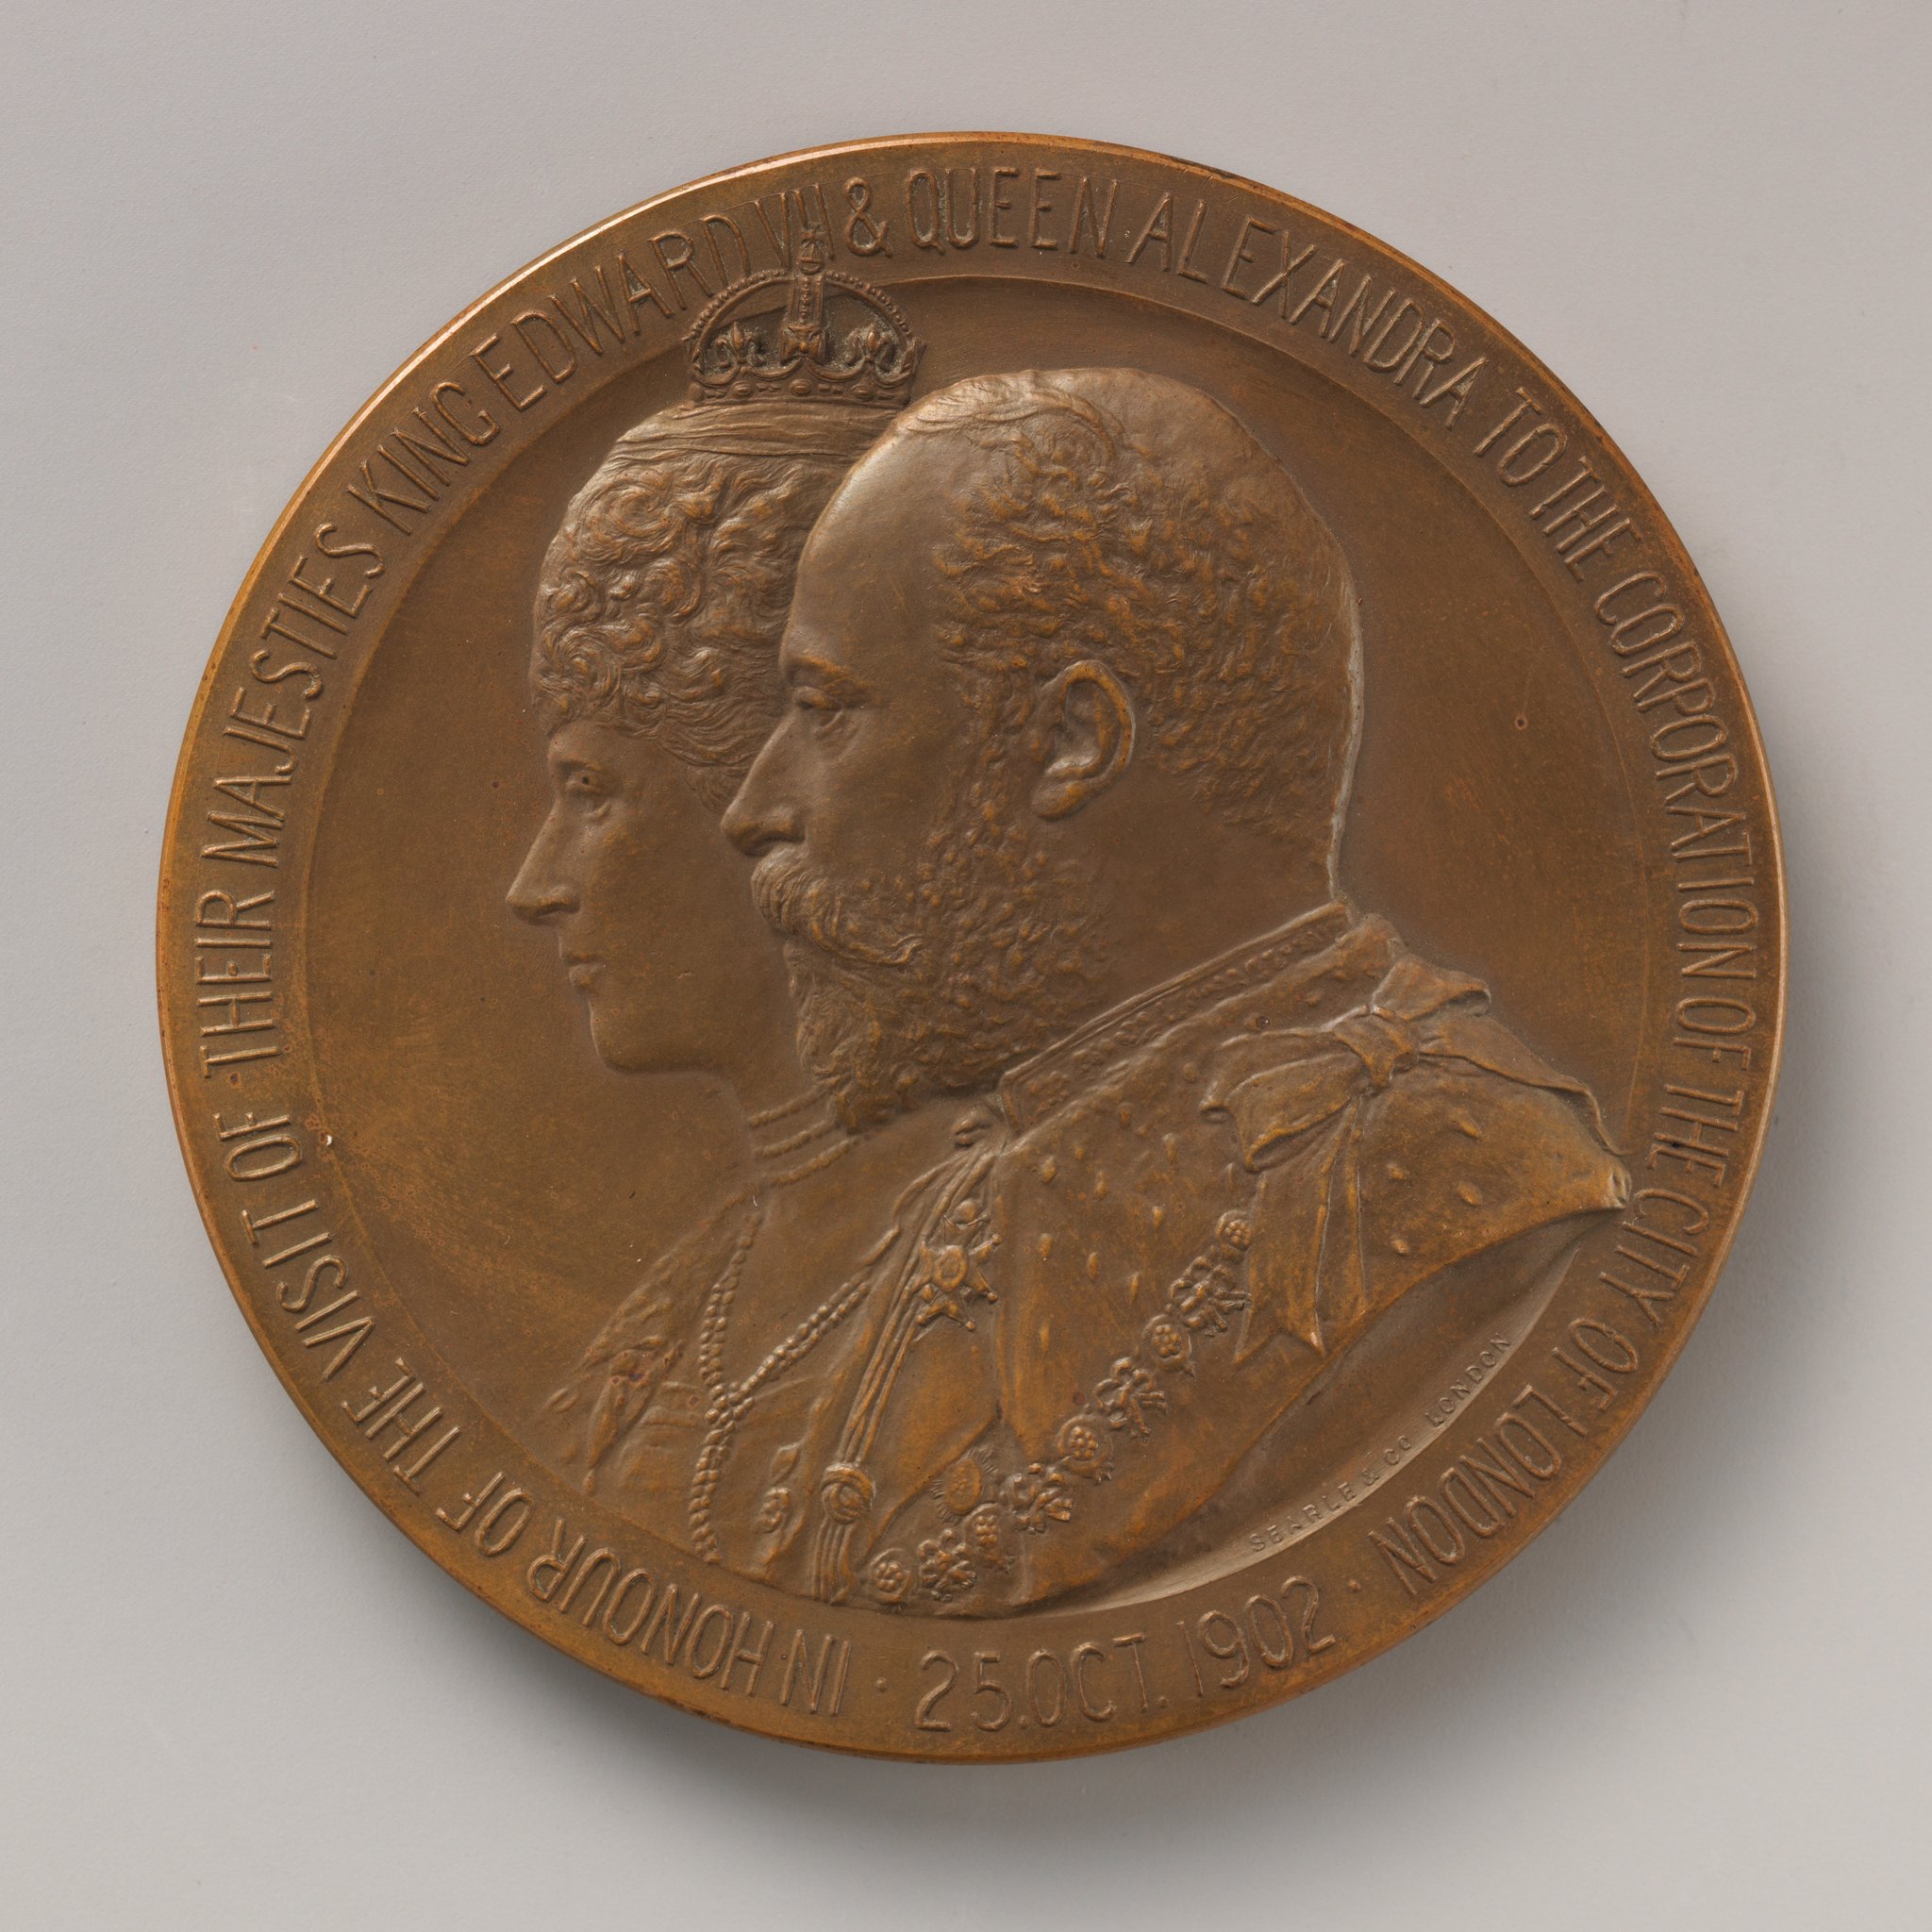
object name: medal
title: By the City of London in Honor of the Coronation of King Edward VII and Queen Alexandra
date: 1902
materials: bronze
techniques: struck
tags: kings,queens,profiles